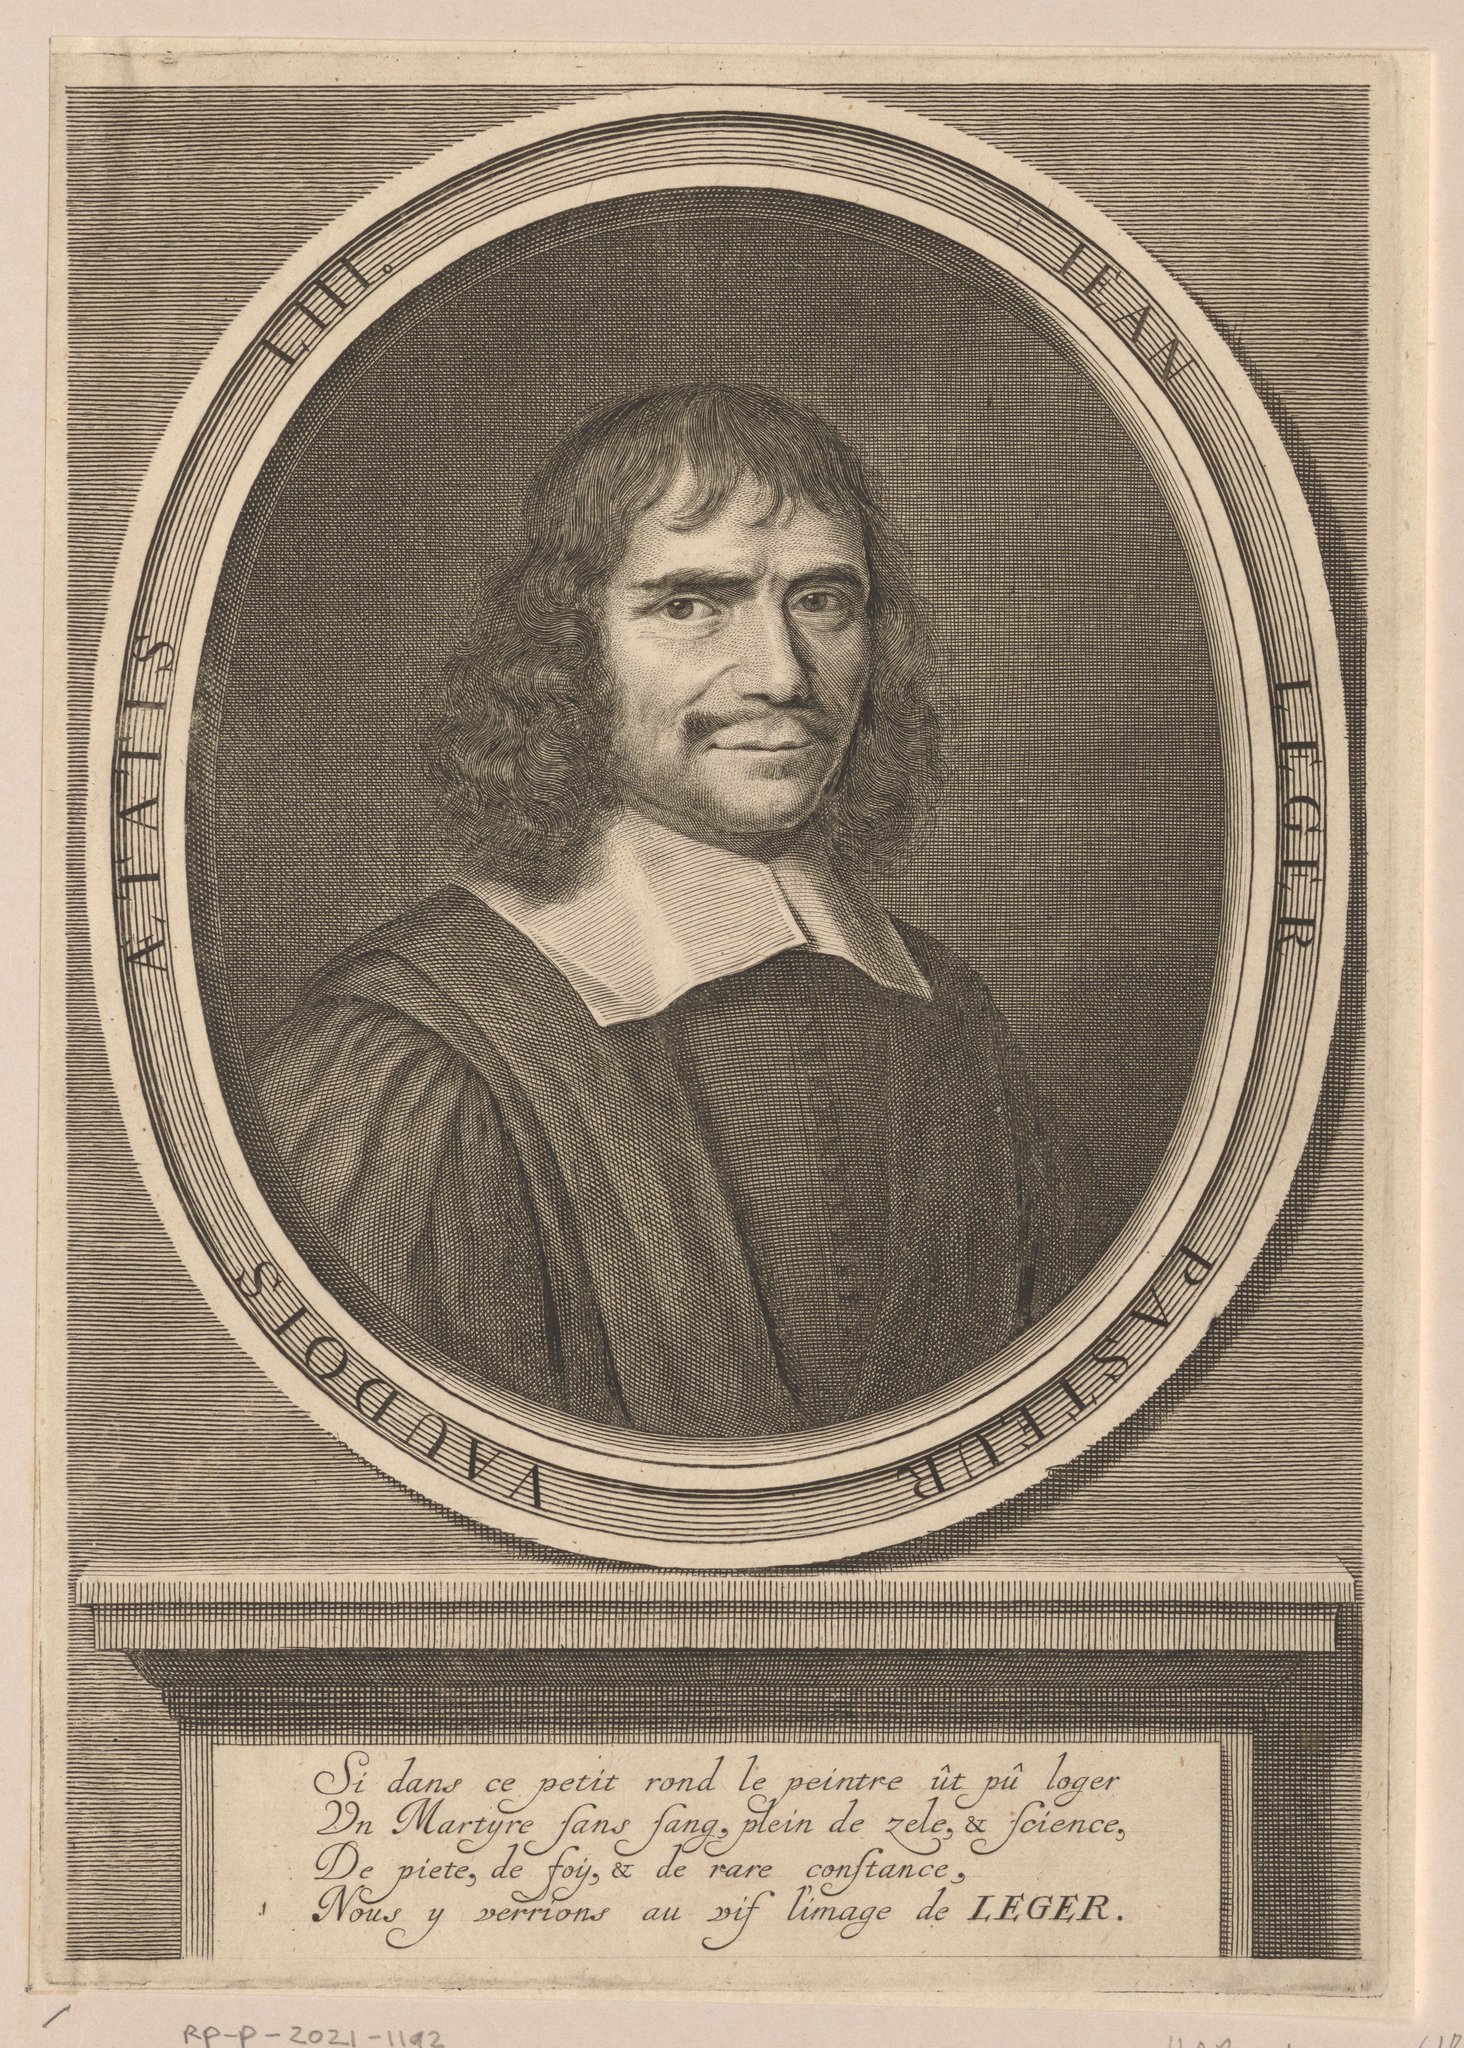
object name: print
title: Portret van Jean Léger op 53-jarige leeftijd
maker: abraham bloteling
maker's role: draughtsman, print maker, publisher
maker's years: 1640-1690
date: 1668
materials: paper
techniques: engraving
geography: amsterdam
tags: ornament ~ medallion, historical persons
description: Met vierregelig vers in het Frans onder het portret.